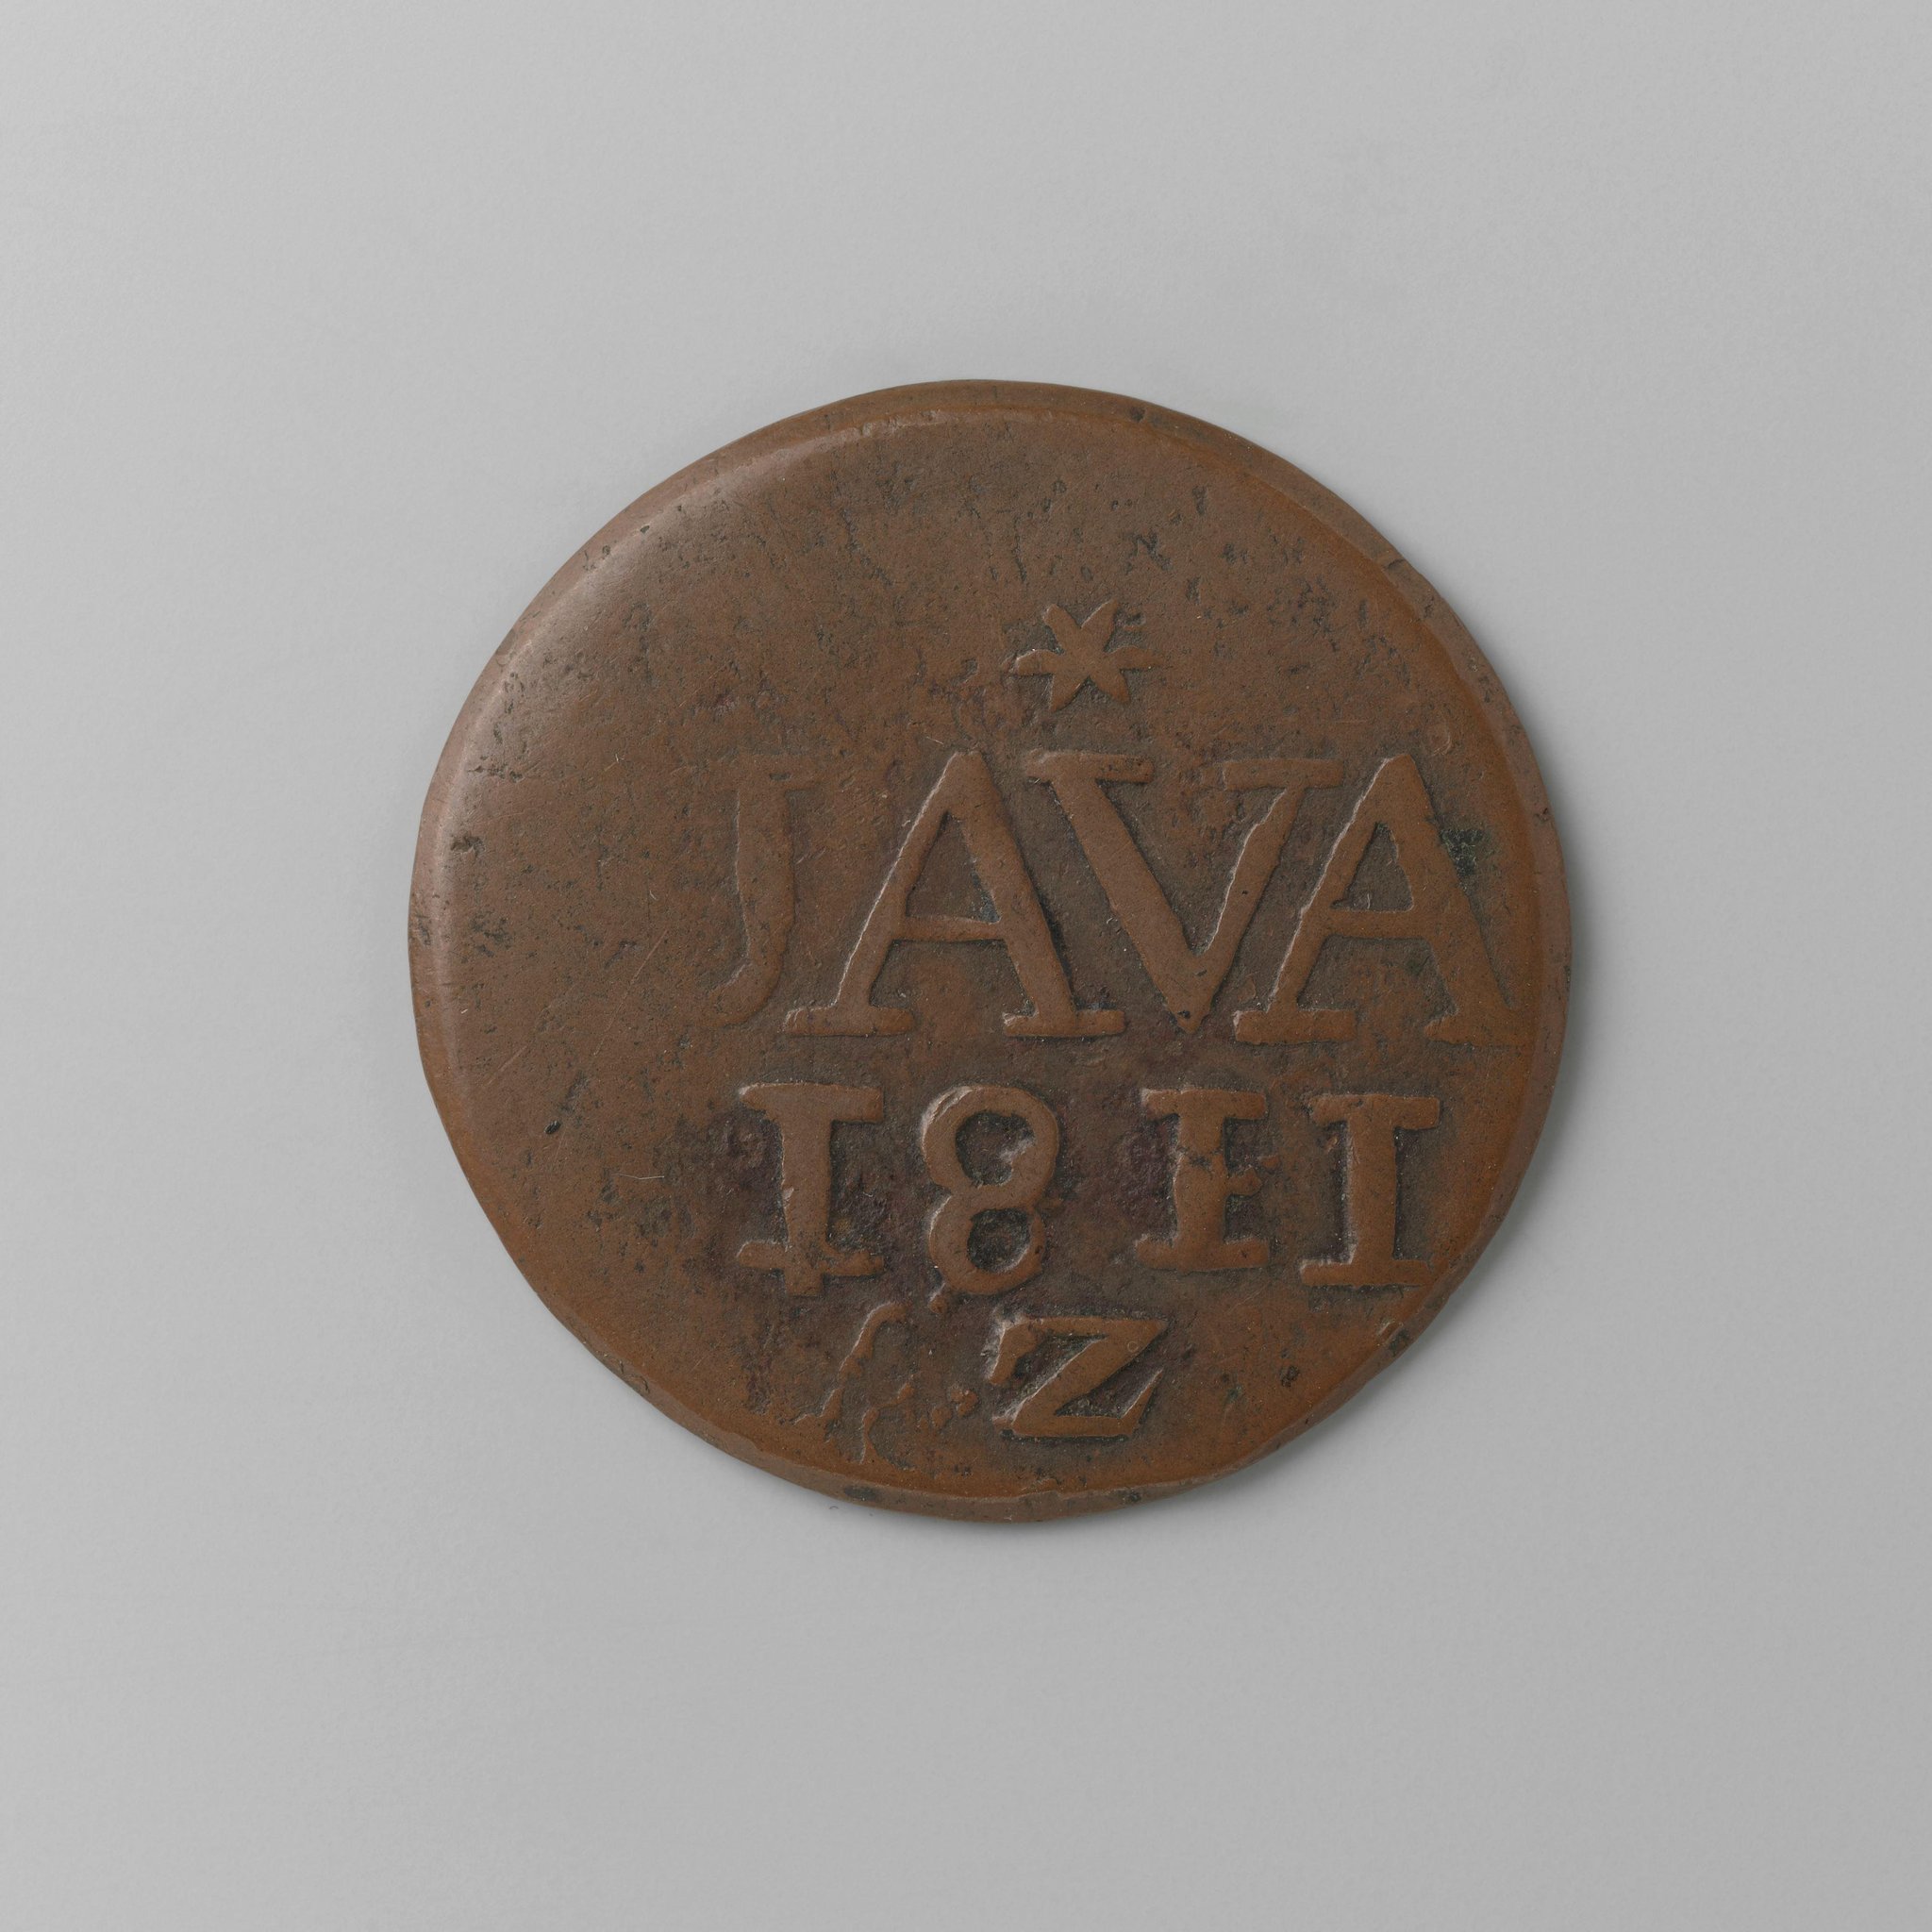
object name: coin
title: Duit voor Nederlands Indië uit Java,1811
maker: napoleon i (emperor of the french)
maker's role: generaal, keizer, staatsman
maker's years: 1769-1821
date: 1811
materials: copper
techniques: striking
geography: surabaya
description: Koperen munt. Voorzijde: initialen L en N van Lodewijk Napoleon. Daarboven muntteken. Keerzijde: eenregelig opschrift, waaronder jaartal. Boven opschrift muntteken en onder jaartal muntmeesterteken Z [=muntmeester Zwekkert].